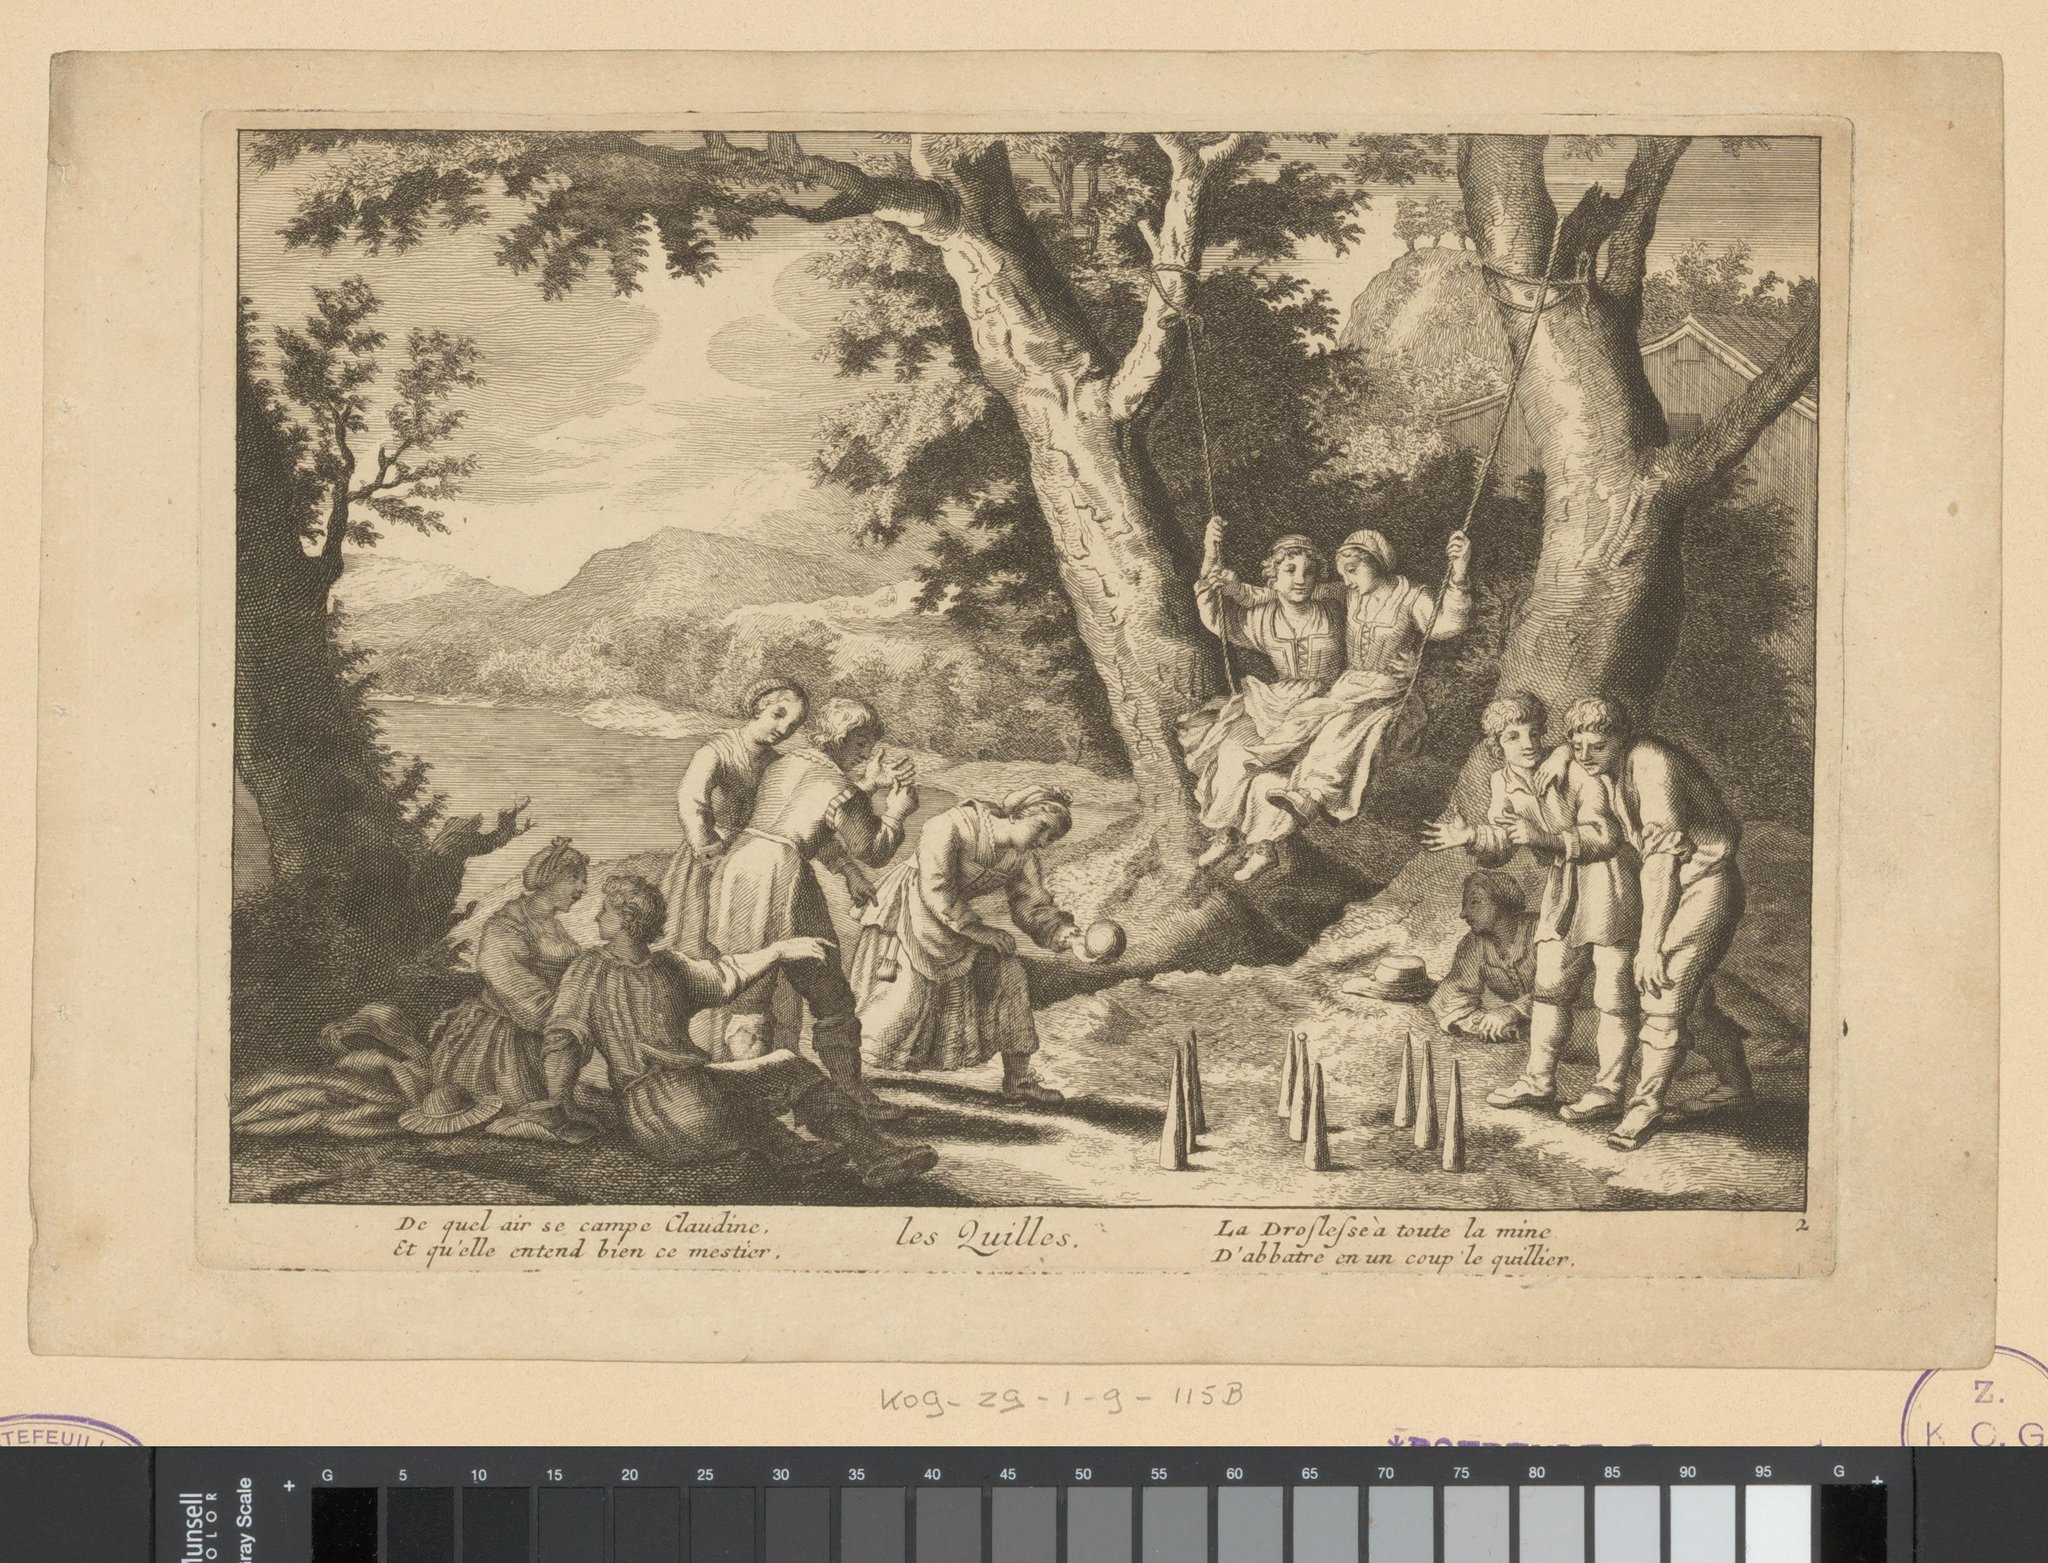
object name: print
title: Landelijke en pastorale scènes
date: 1670-1726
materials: paper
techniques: engraving, etching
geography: amsterdam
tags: swinging (children's game), ninepins, skittles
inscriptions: stamp:, collector's mark: Lugt 1641, stamp:, collector's mark: Lugt 1641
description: Onderaan genummerd: 2. Onderwerpsrubrieken binnen de Atlas Zeden en Gewoonten: Handel, nijverheid en verkeer, Boerenleven.